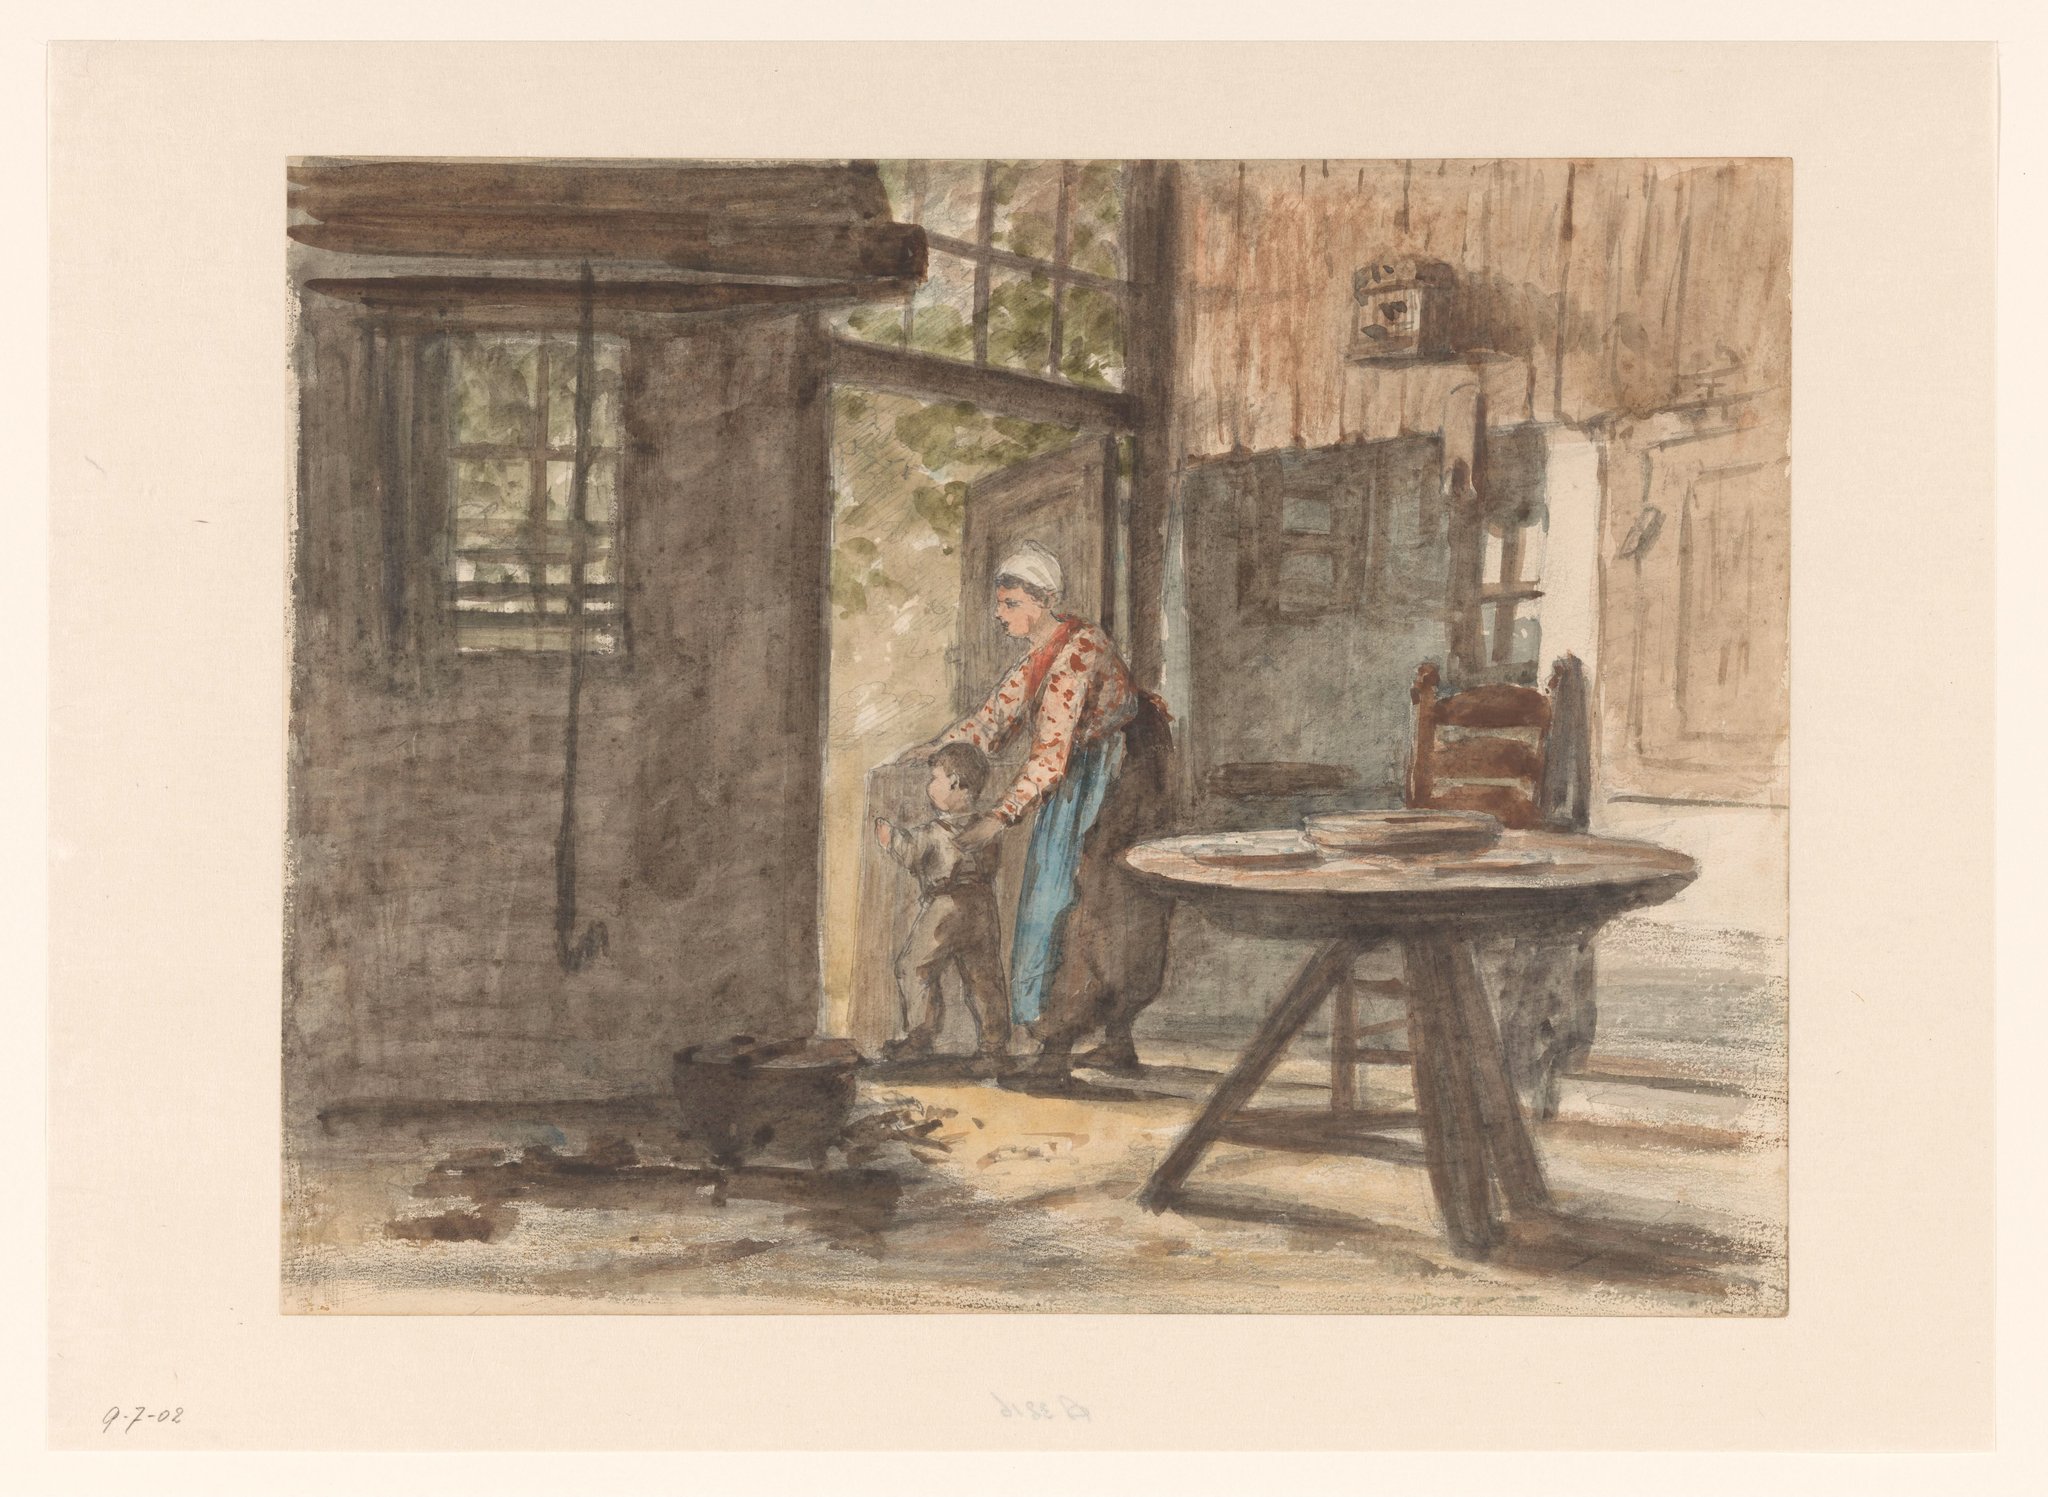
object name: drawing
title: Handwerkende vrouw en kind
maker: hendrik valkenburg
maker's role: draughtsman, painter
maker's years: 1826-1896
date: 1836-1896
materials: chalk, paper, pencil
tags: family life, interior of the house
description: Schetsblad met interieur met handwerkende vrouw en kind. Verso: vrouwen en kinderen.